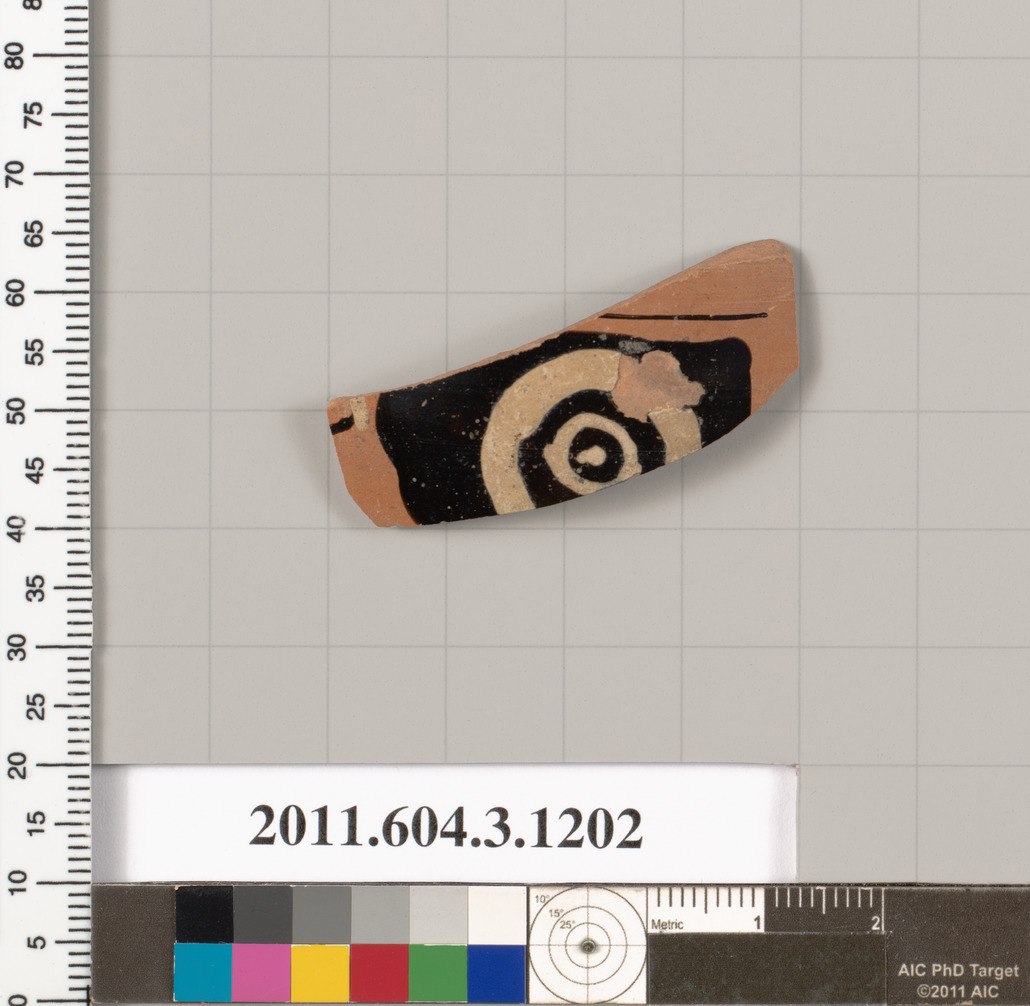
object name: mastoid fragment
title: Terracotta fragment of a mastoid (drinking cup with narrow base)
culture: greek, attic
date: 534-468 BCE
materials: terracotta